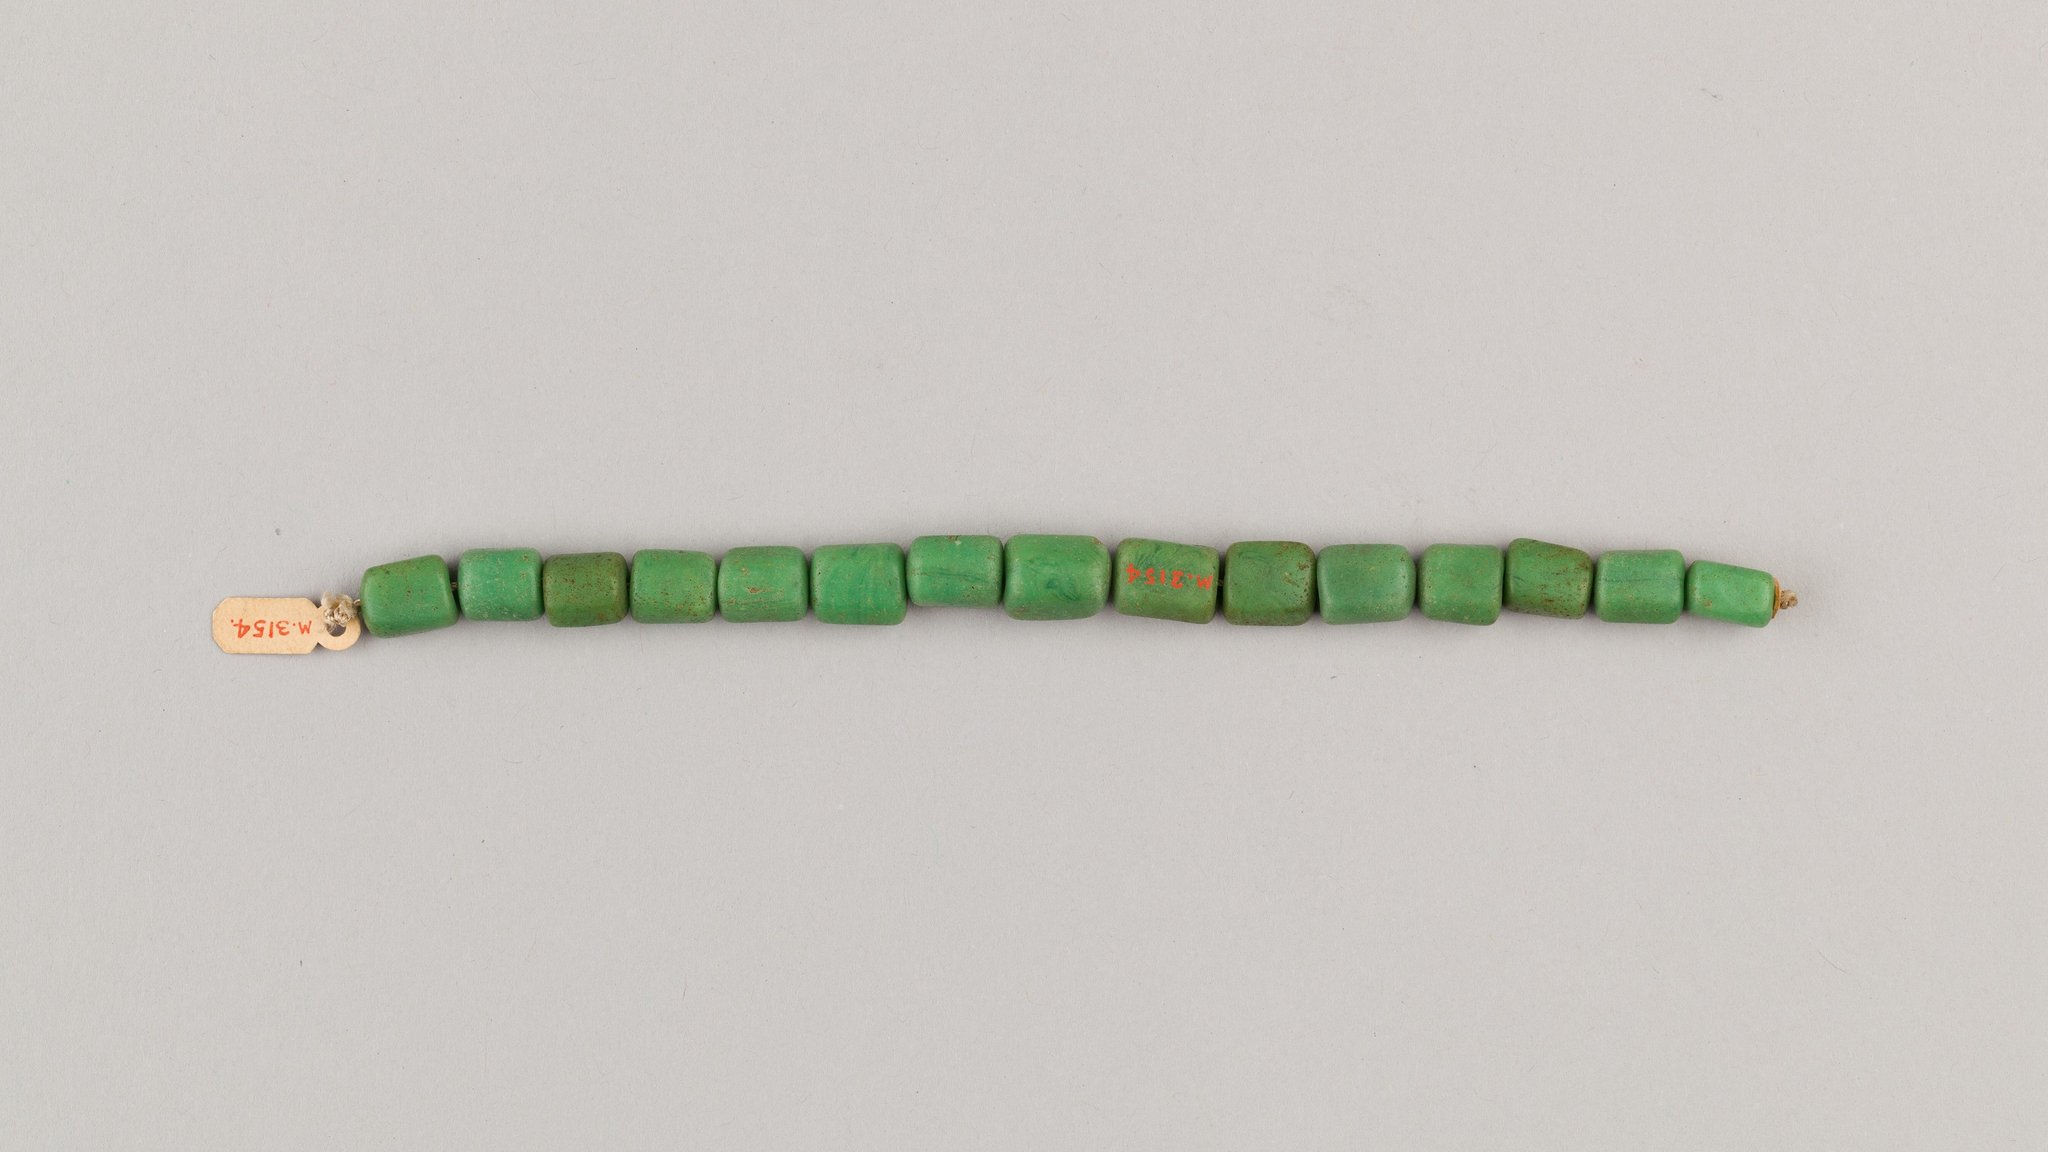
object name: bead, string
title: String of 15 hexagonal beads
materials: glass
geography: egypt